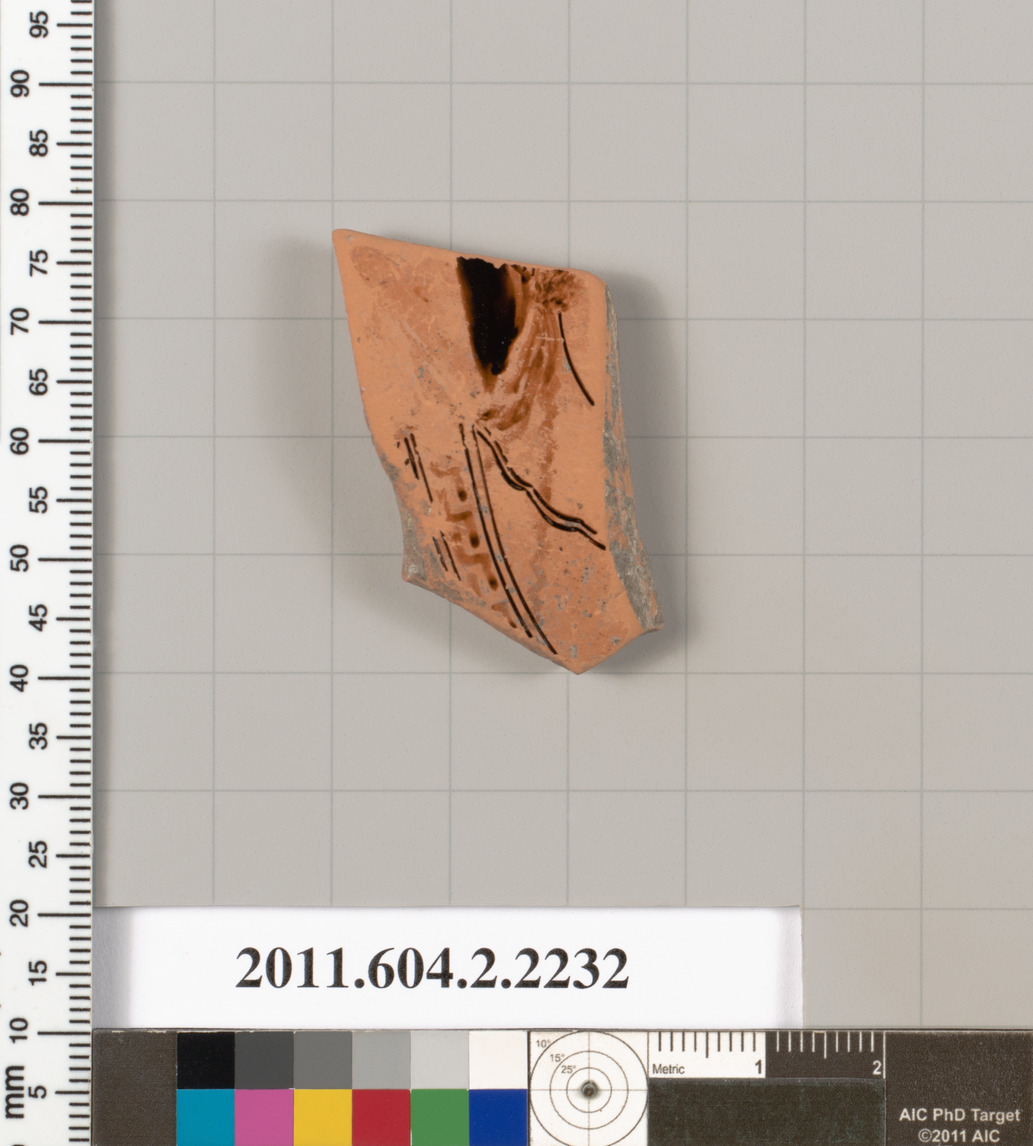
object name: pot fragment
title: Terracotta fragment of a pot; unglazed on the inside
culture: greek, attic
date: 460-440 BCE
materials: terracotta